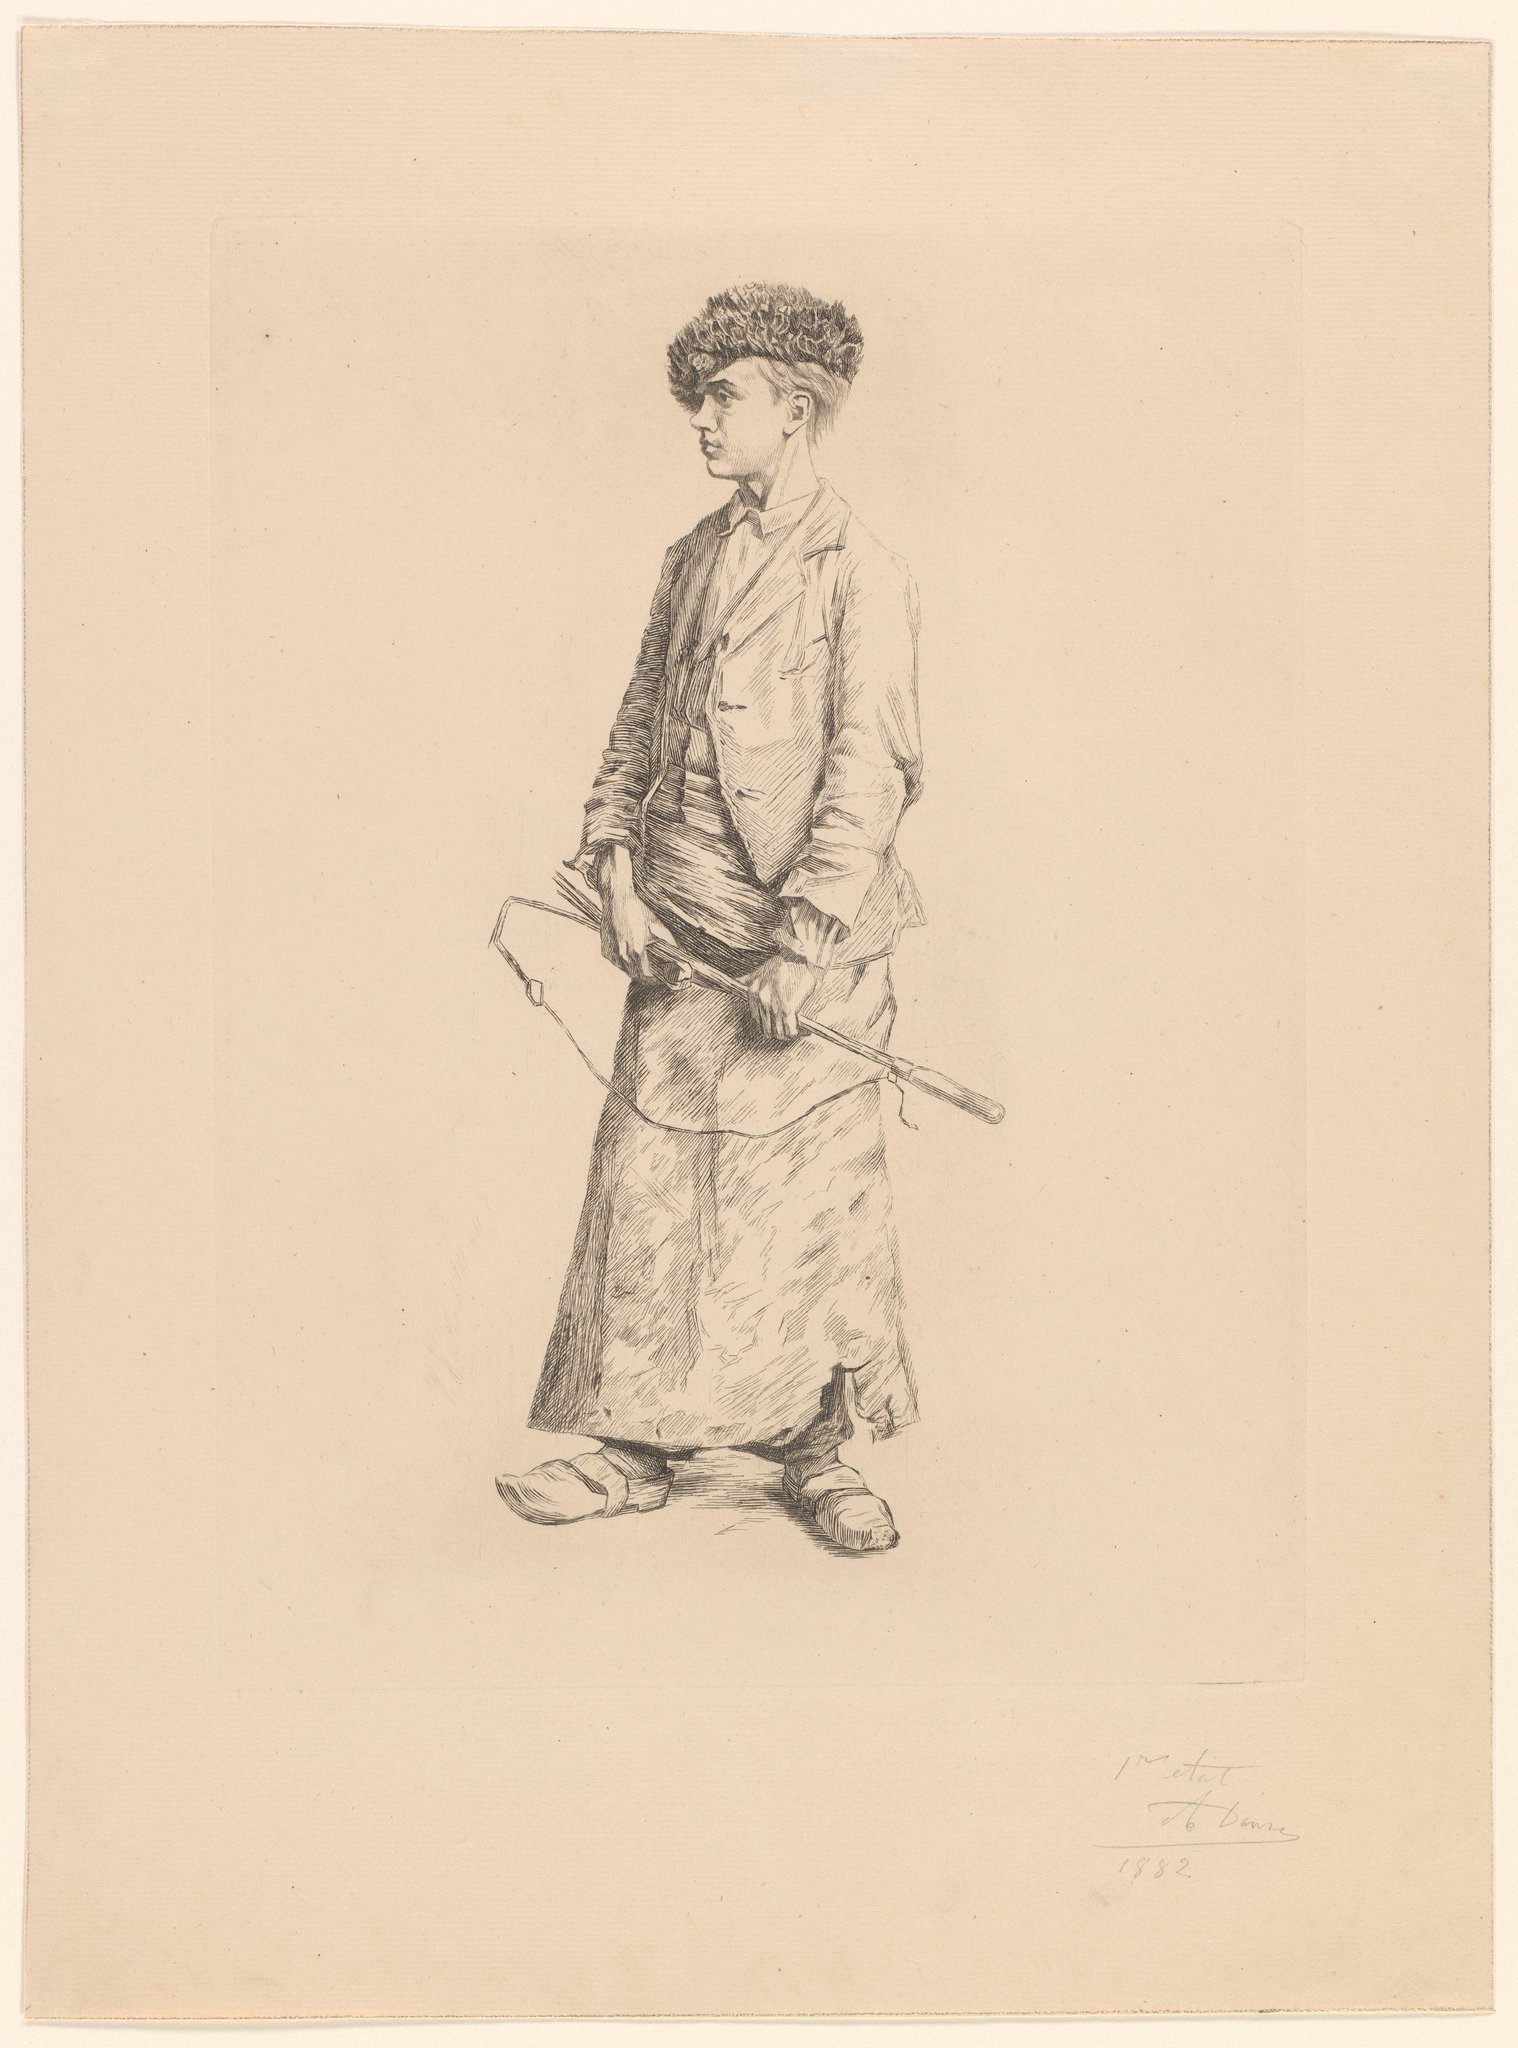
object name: print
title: Smidsjongen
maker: auguste danse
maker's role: print maker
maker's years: 1829-1929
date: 1882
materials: paper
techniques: etching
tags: smith, blacksmith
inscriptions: collector's mark: Lugt 2228, annotation: ‘1er etat’